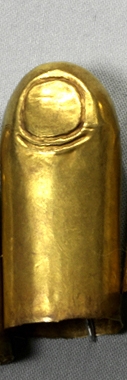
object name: finger stall, group 2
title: Finger stall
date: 1479-1425 BCE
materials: gold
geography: egypt